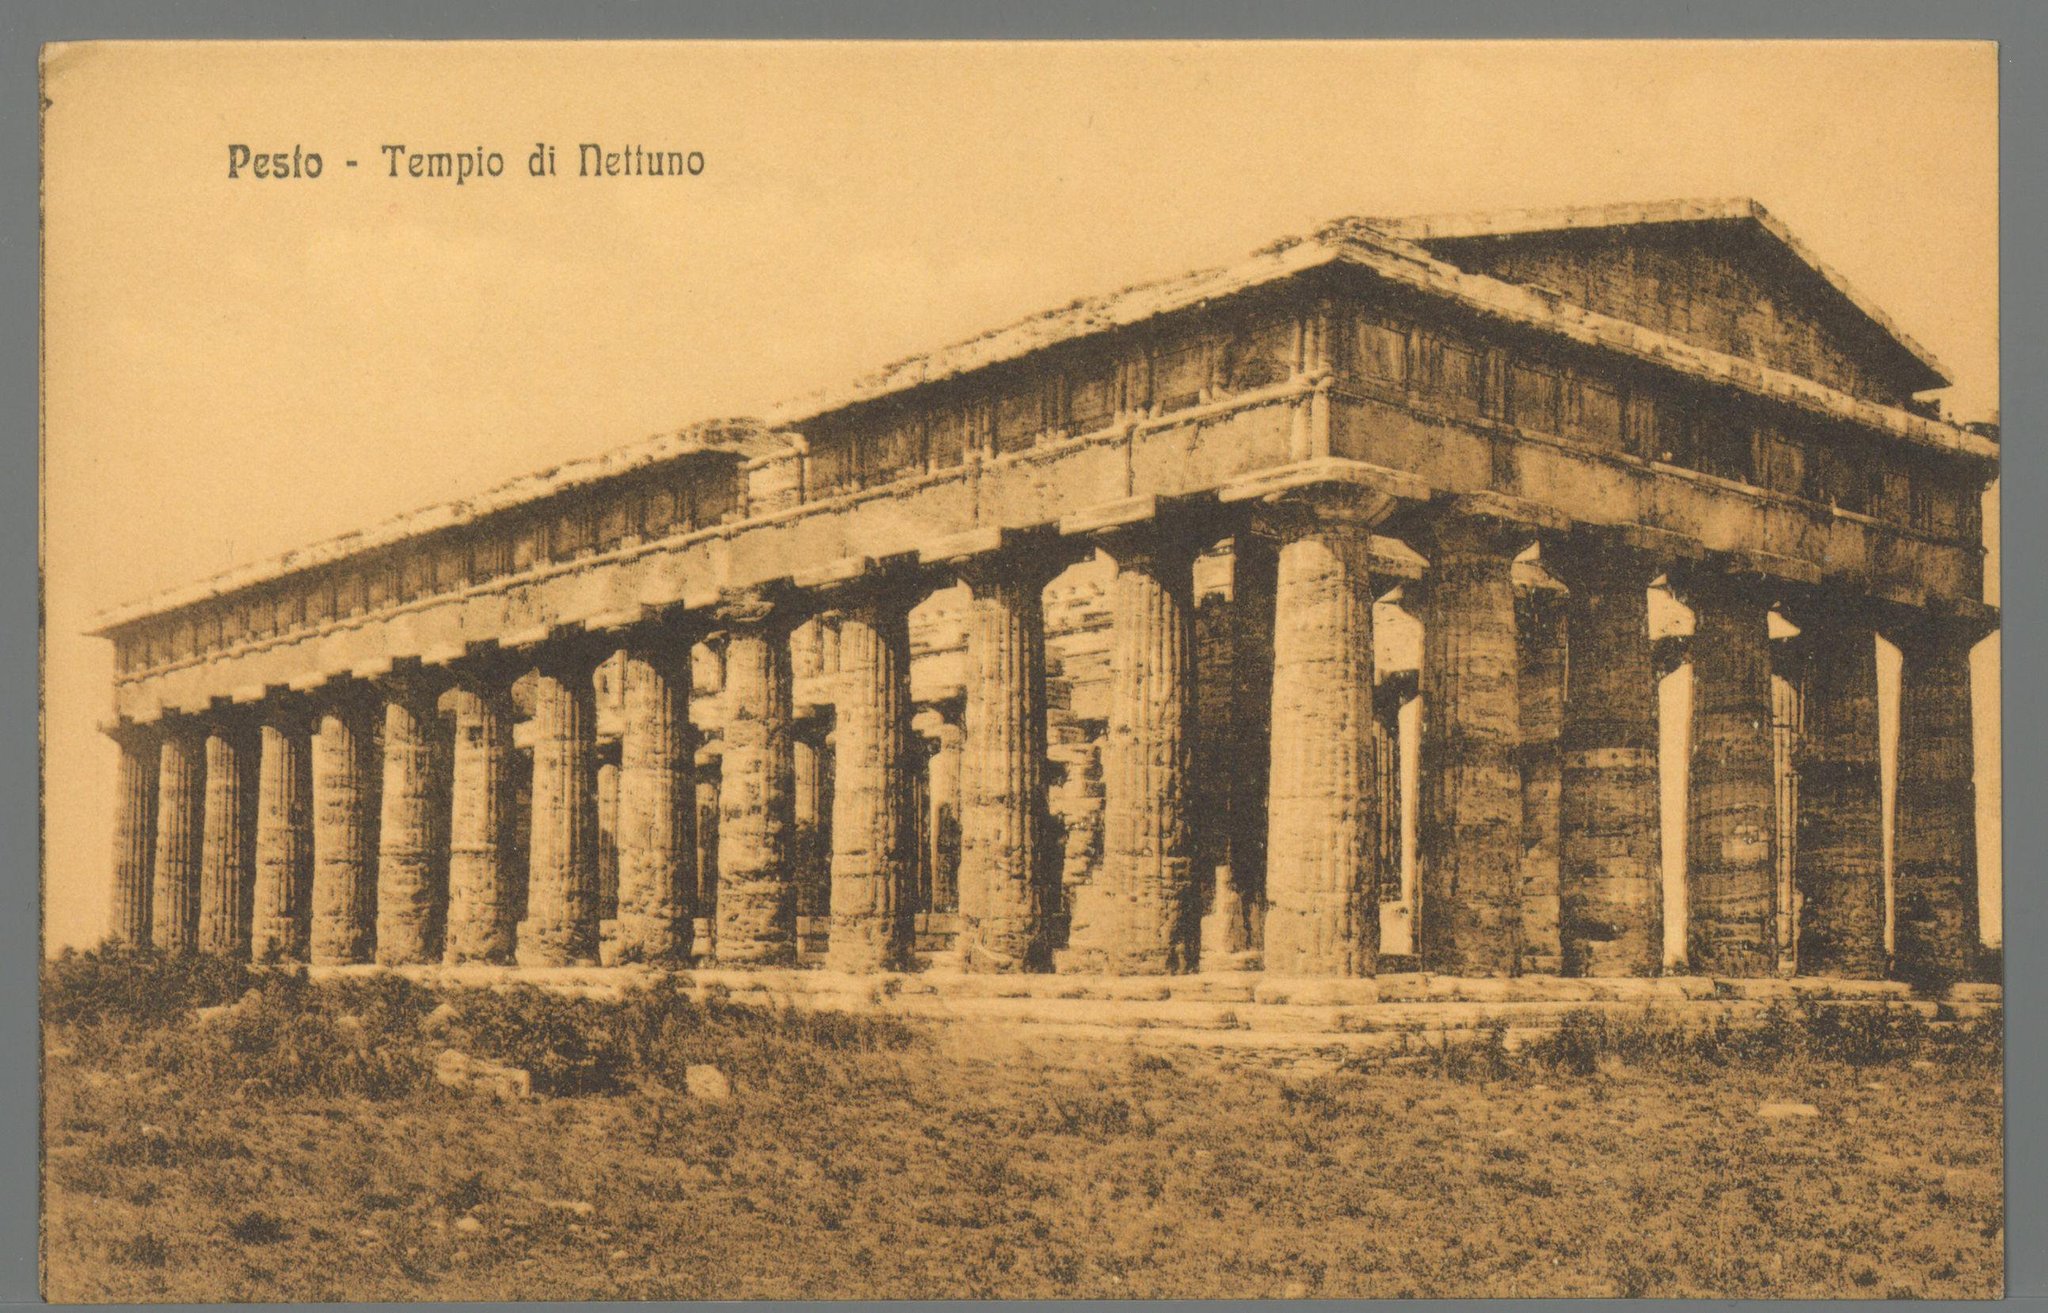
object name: photomechanical print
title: Pesto. Tempio di Nettuno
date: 1906-1930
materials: cardboard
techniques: photograph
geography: salerno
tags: column, pillar ~ architecture, temple, shrine ~ roman religion